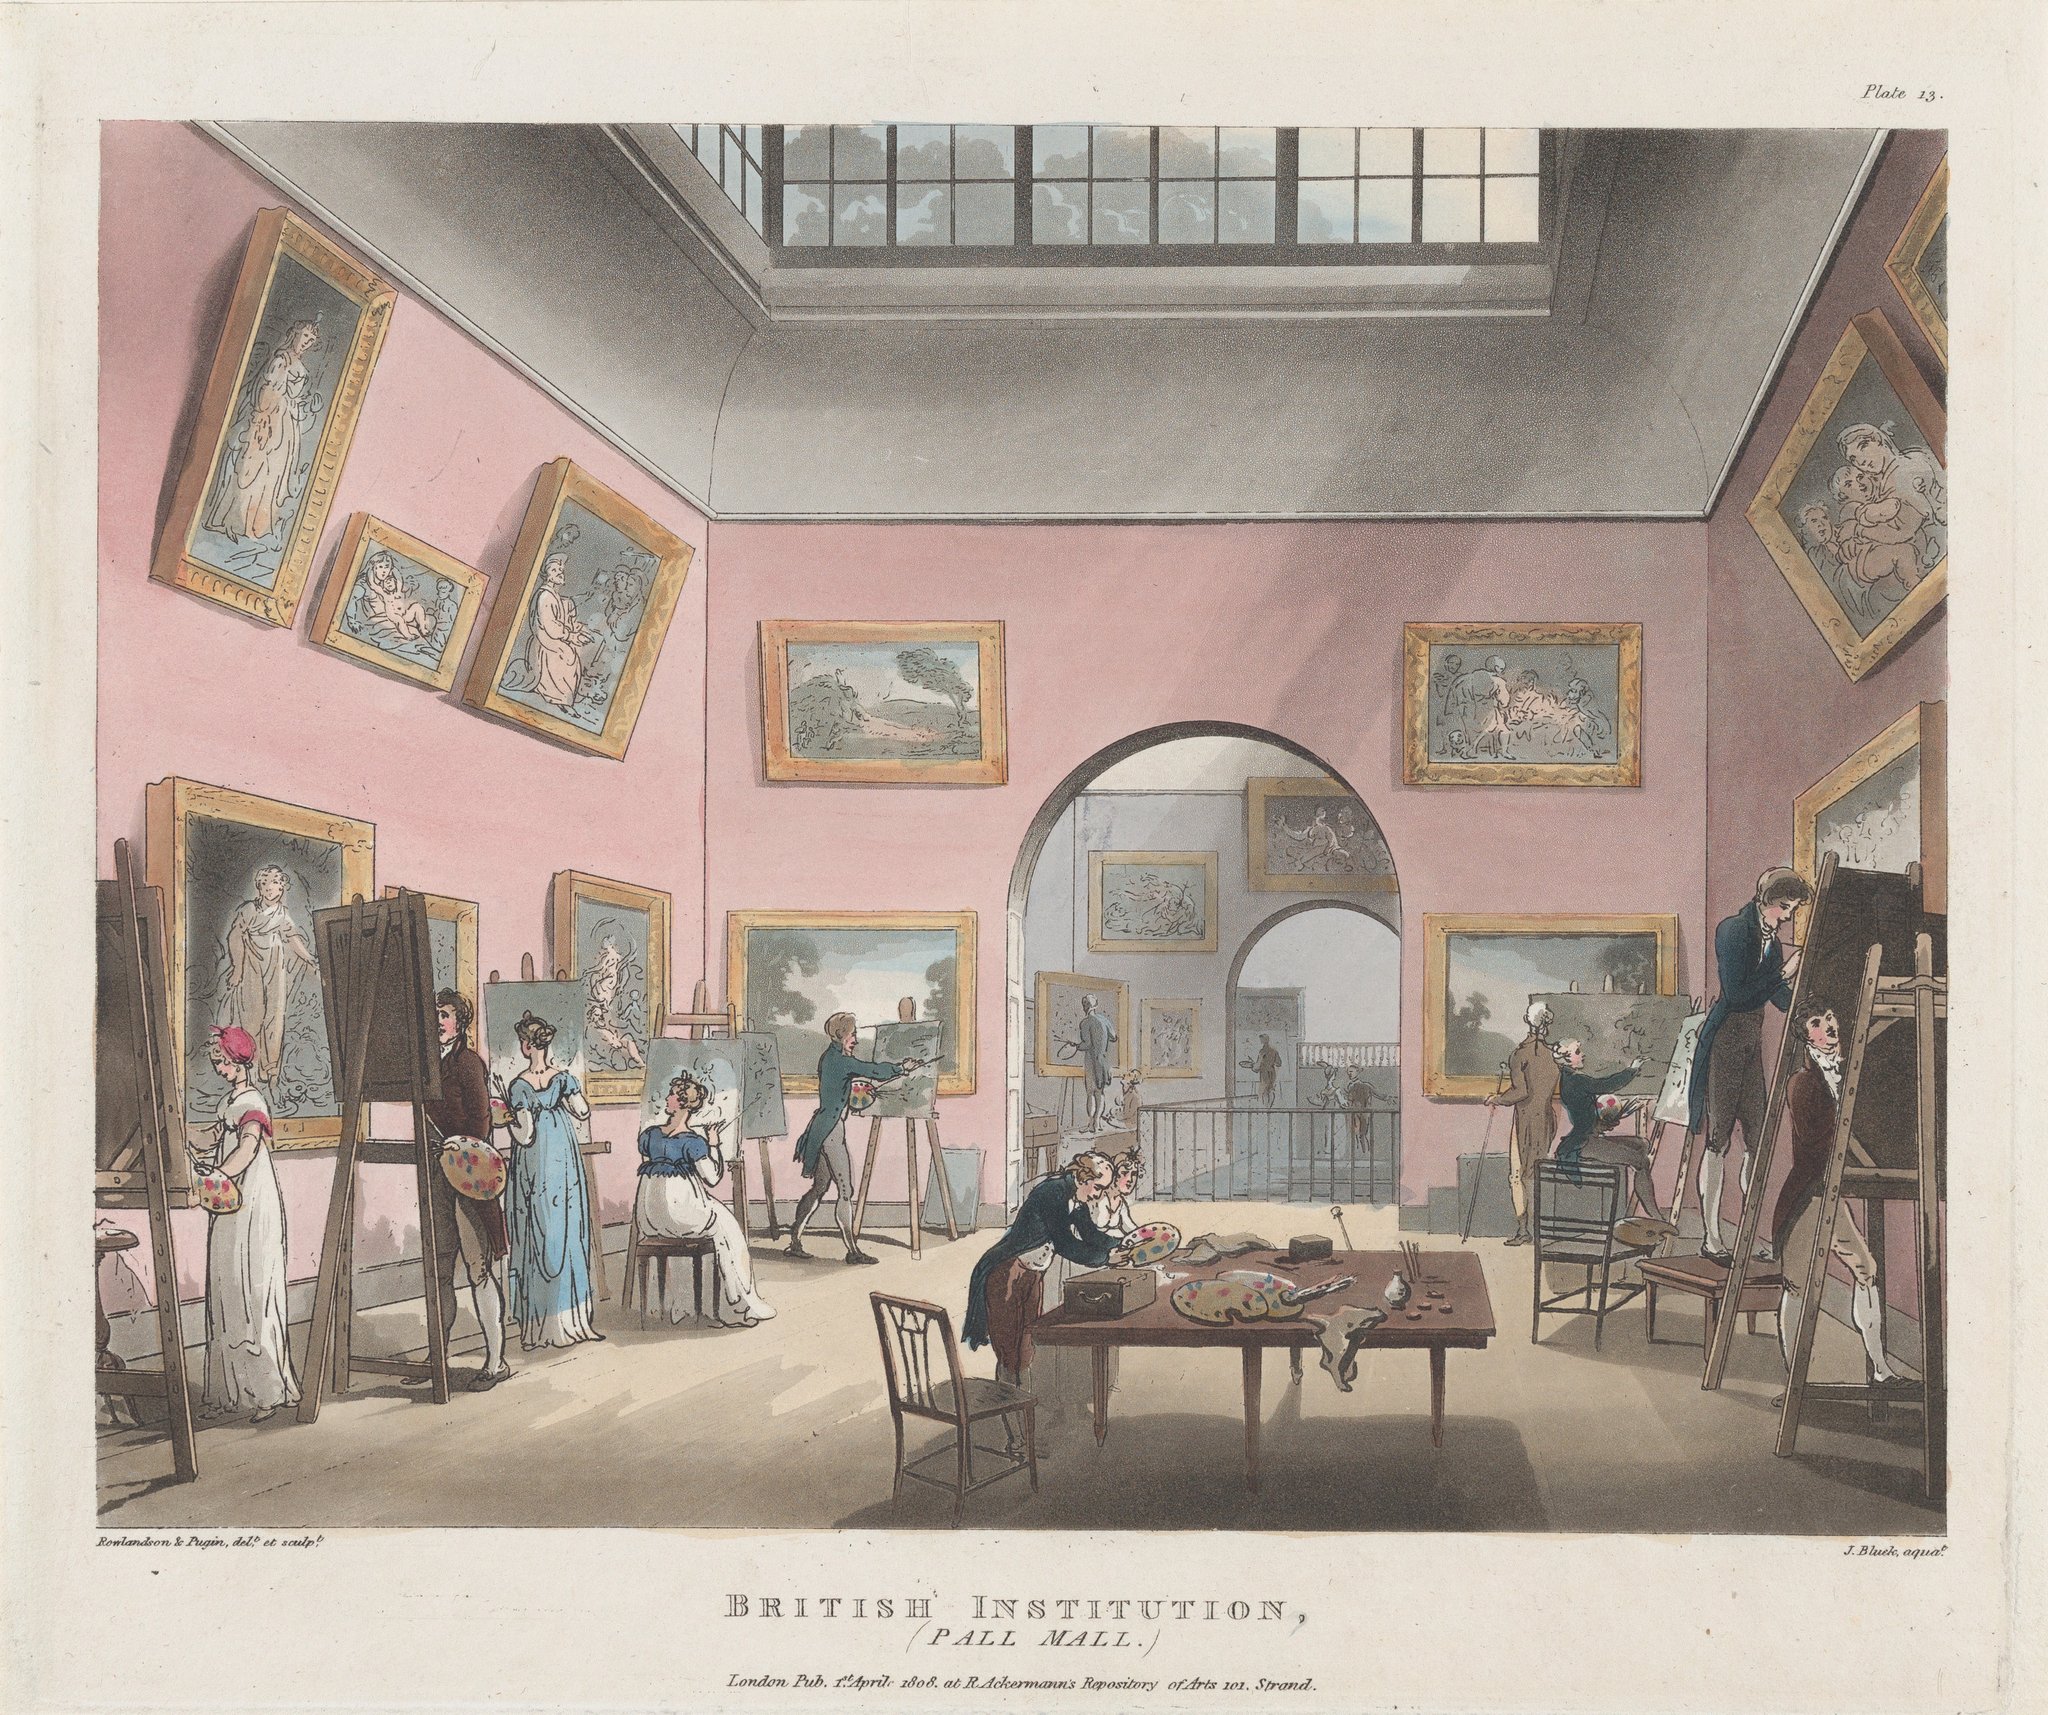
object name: print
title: The British Institution, Pall Mall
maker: thomas rowlandson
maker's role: artist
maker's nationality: british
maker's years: 1757-1827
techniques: aquatint, etching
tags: painting,interiors,men,women,education,easels,palettes,london